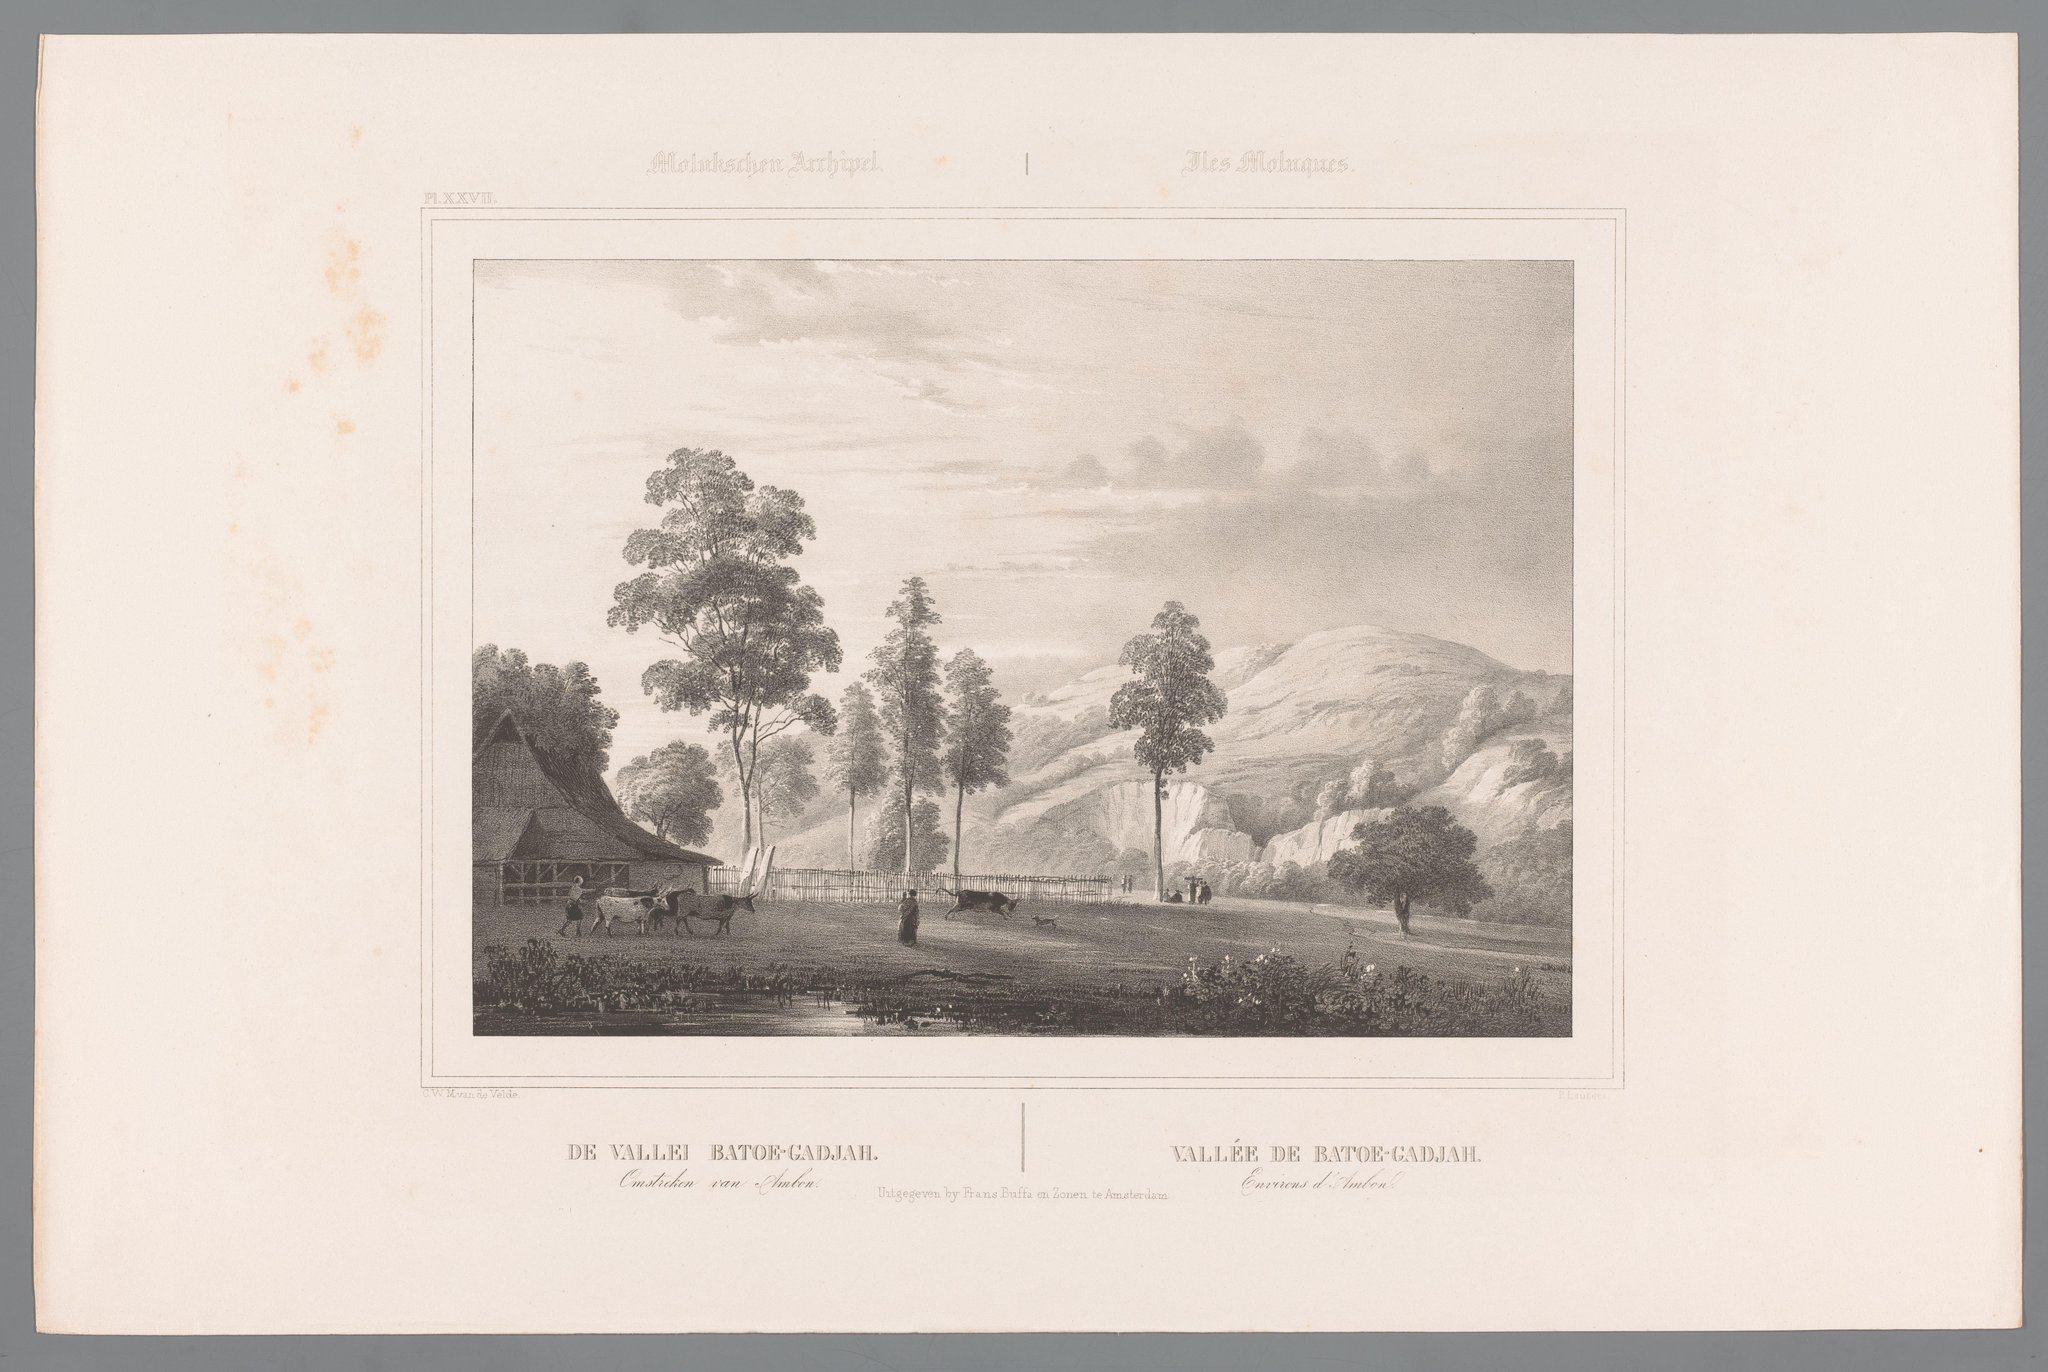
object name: print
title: Gezigten uit Neêrlands Indië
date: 1847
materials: paper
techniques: lithograph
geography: amsterdam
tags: cow, dale, valley (+ landscape with figures, staffage), herd, flock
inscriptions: collector's mark: Lugt 2228